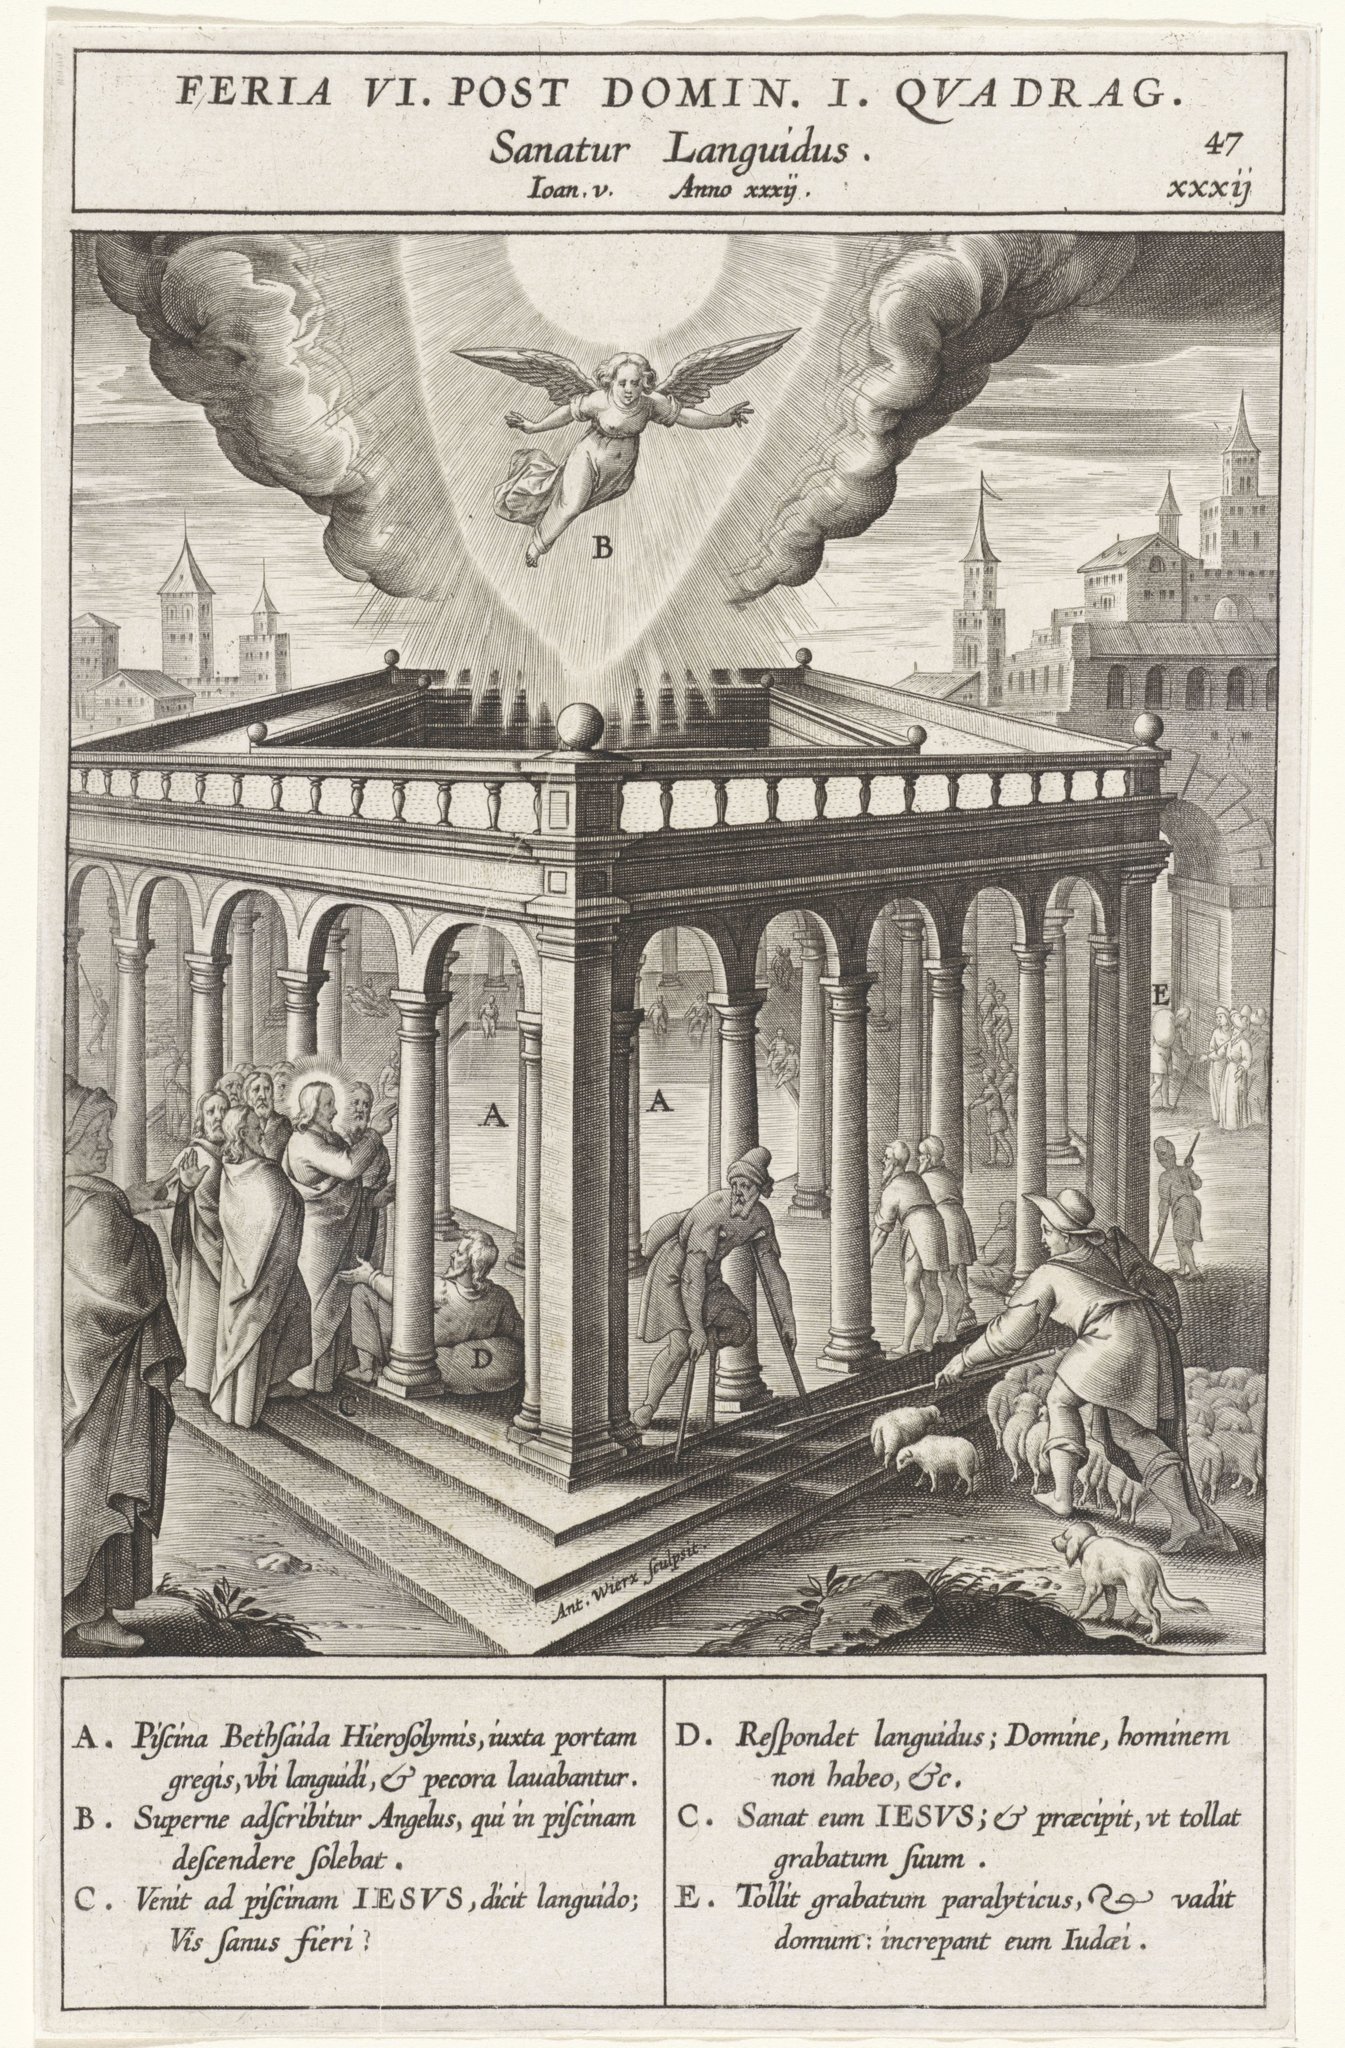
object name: print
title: Christus geneest de zieke van Betzata (Bethesda)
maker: antonie wierix (ii)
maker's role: draughtsman, print maker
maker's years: 1555-1604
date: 1593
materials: paper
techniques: engraving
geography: antwerp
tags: disabilities, deformations, christ says to a paralytic man: 'rise, take up your pallet (bed)', sick people lying near the pool of bethesda ~ christ healing paralytics (john 5:1-9)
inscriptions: collector's mark: Lugt 2165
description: Genezing op sabbat. Christus geneest een man die al achtendertig jaar ziek is bij het bad van Betesda (Betzata). Rond het water zitten zieke en blinde mensen en mensen met beperkingen. In de lucht vliegt een engel. Bij verschillende elementen uit de voorstelling staan letters die corresponderen met de legenda in de marge.